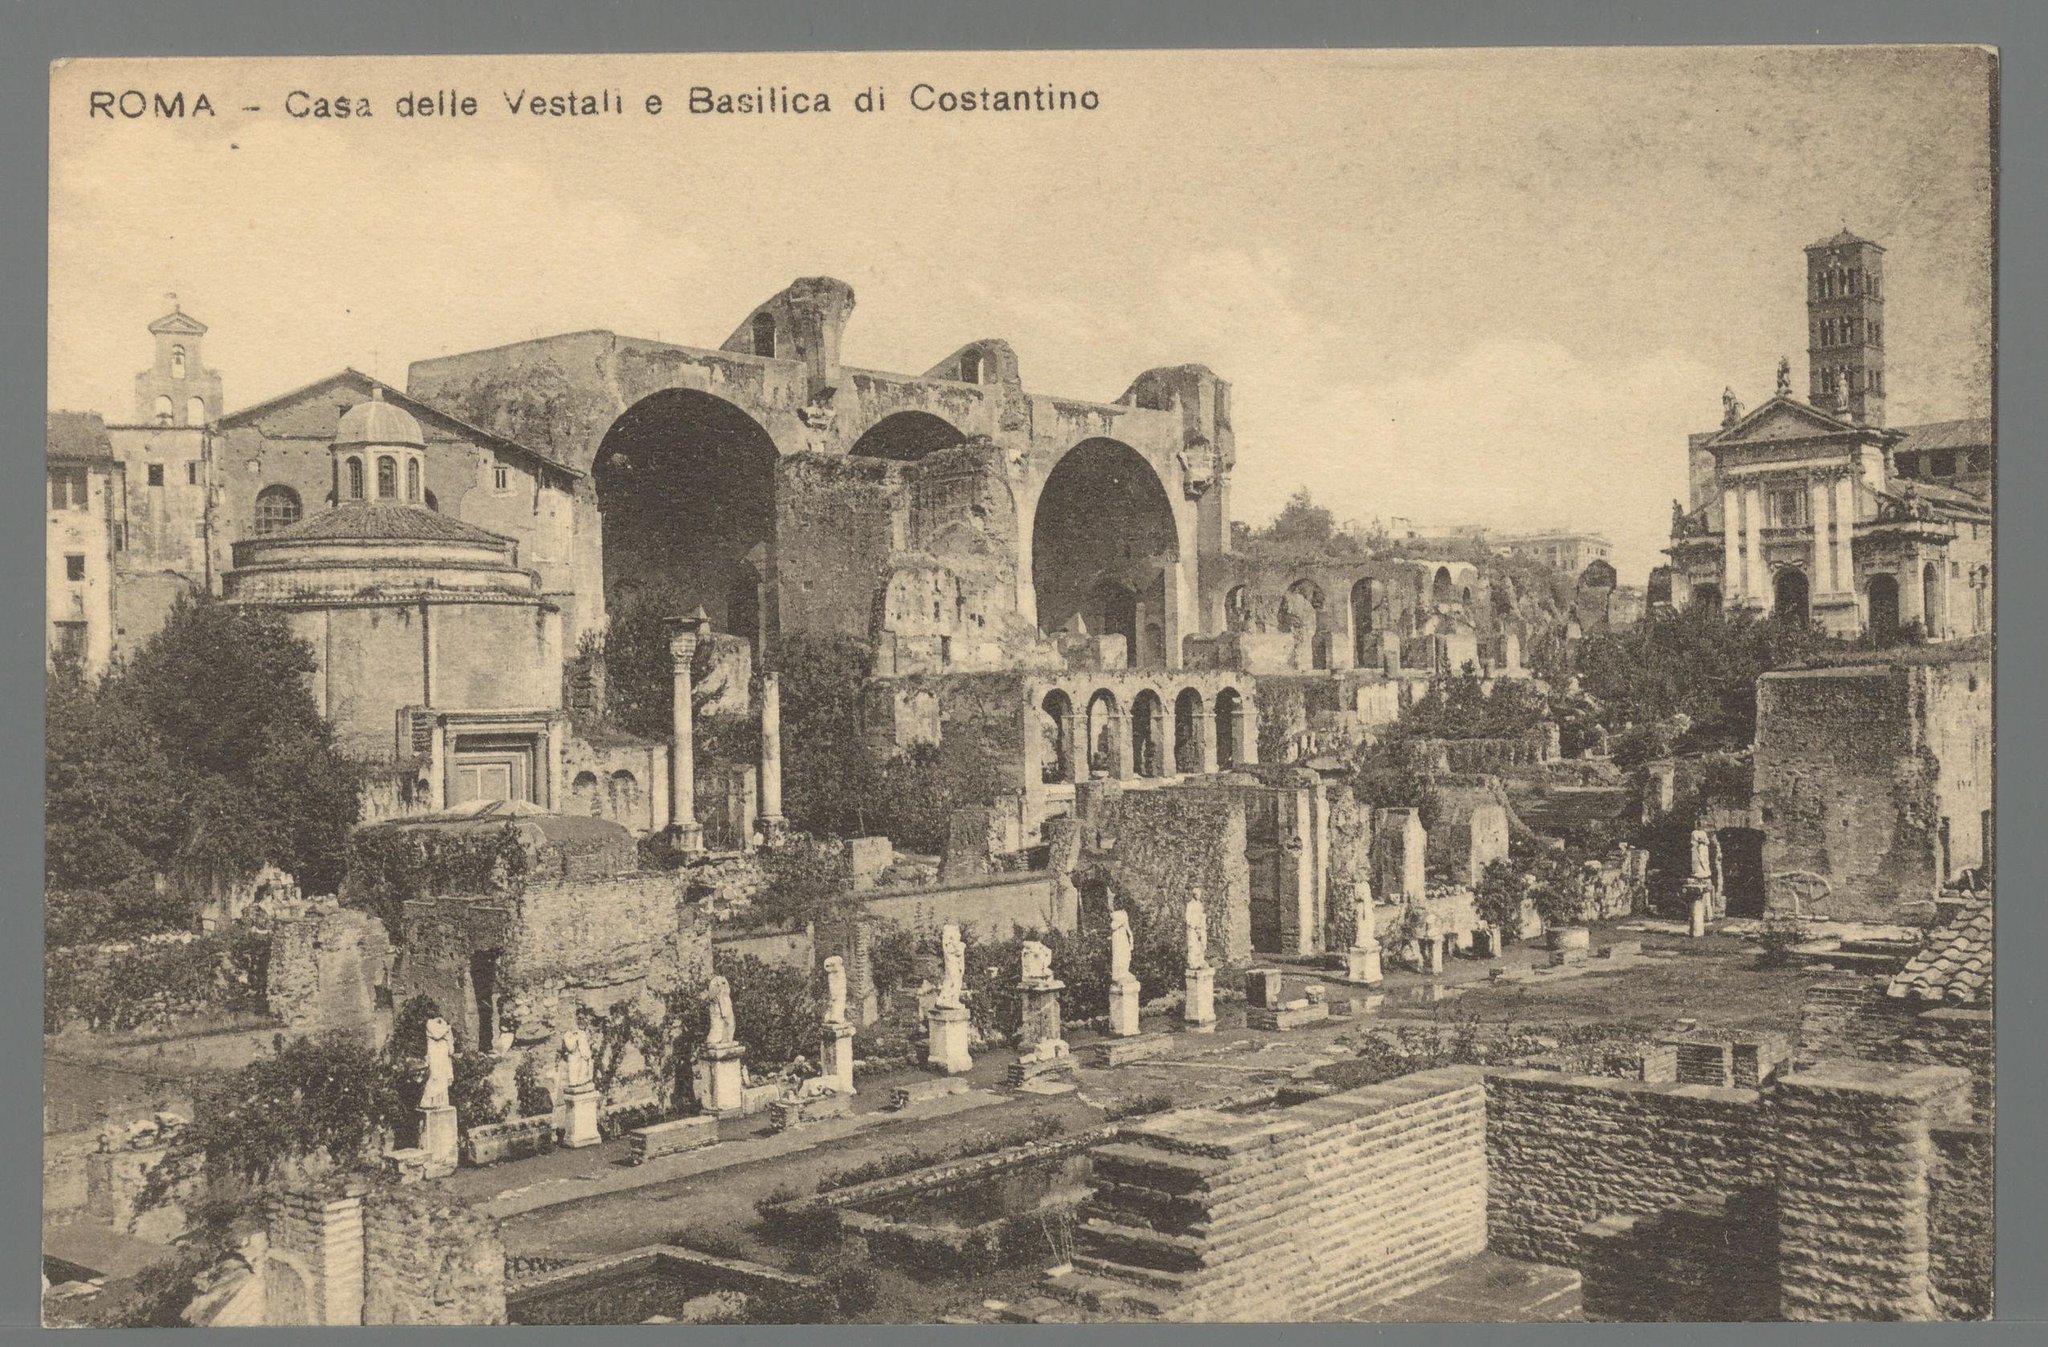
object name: photomechanical print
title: Roma. Casa delle Vestali e Basilica di Costantino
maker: Anonymous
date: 1906-1920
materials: cardboard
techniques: photograph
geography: rome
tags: ruin of a building ~ architecture, church (exterior), excavation ~ archaeology